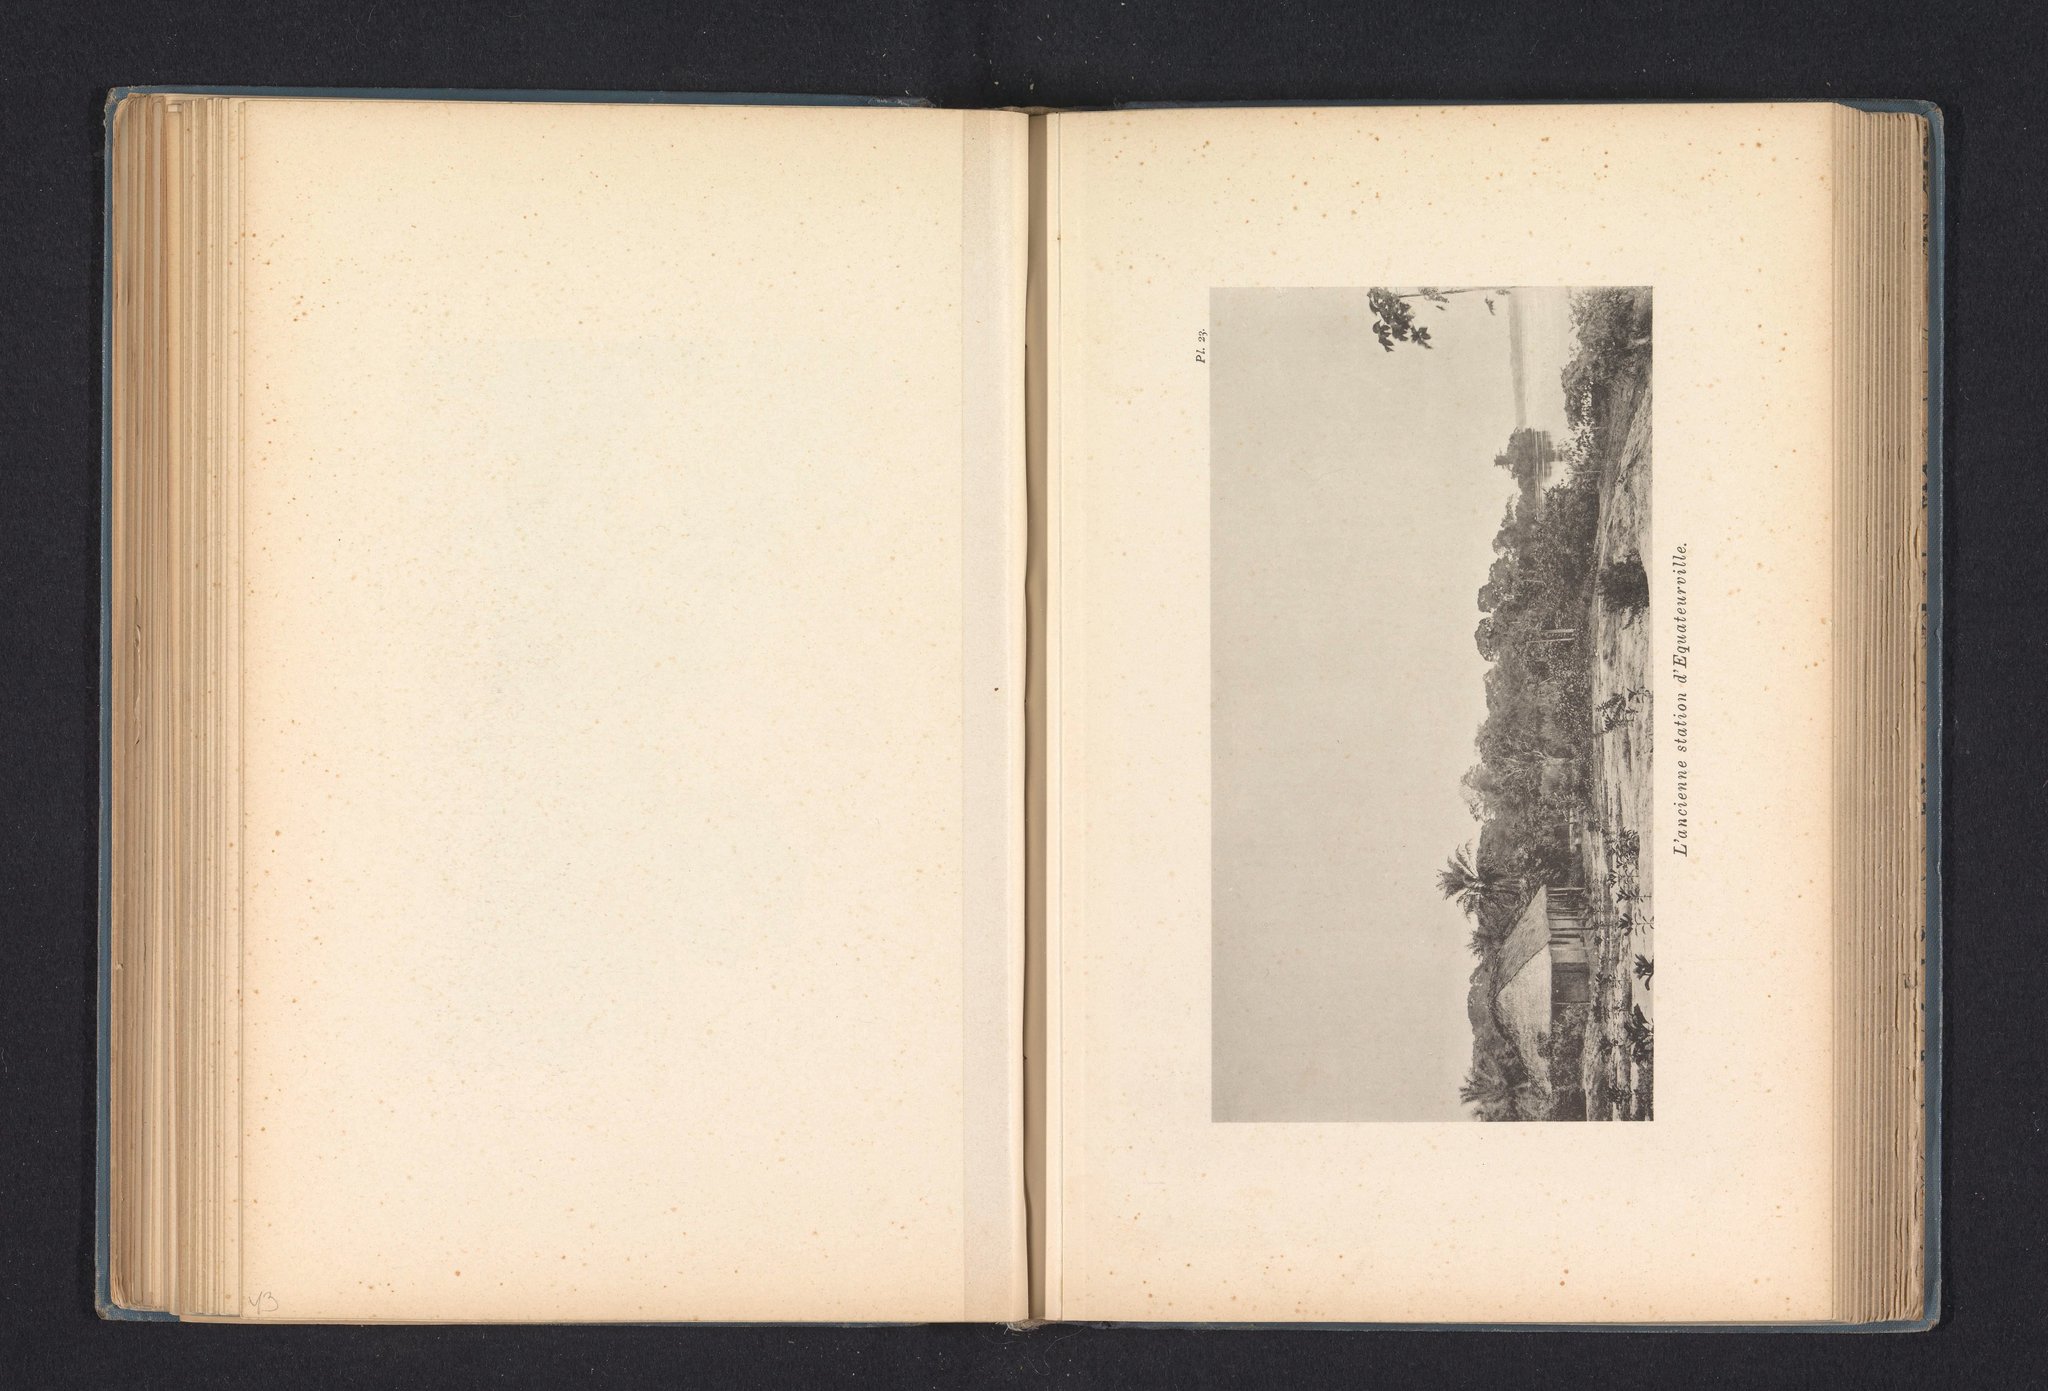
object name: page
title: Exterieur van het stationsgebouw te Equateurville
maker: franz thonner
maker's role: botanicus, ontdekkingsreiziger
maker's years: 1863-1928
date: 1896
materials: paper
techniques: photograph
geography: equateurville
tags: façade (of house or building), station; shelter (railway, tramway)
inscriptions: number: ‘Pl. 23.’